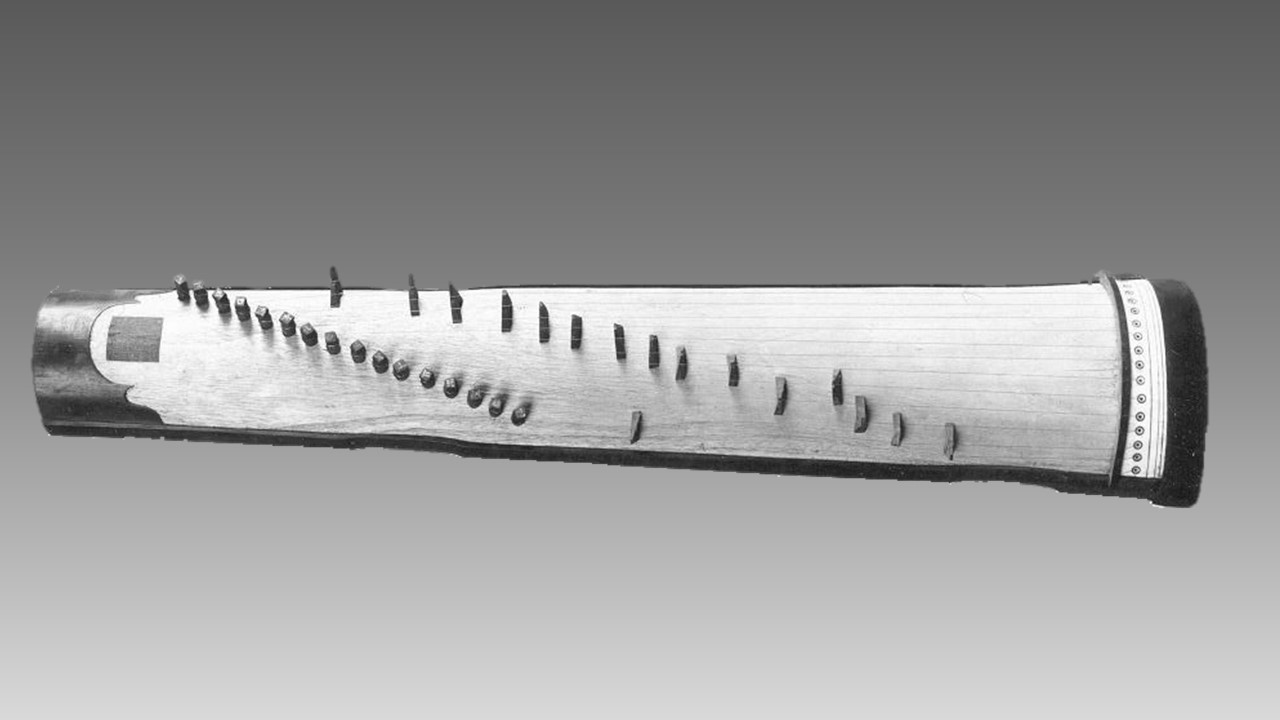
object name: zheng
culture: chinese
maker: k'ai -sheng shop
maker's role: maker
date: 1801-1900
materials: wood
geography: china